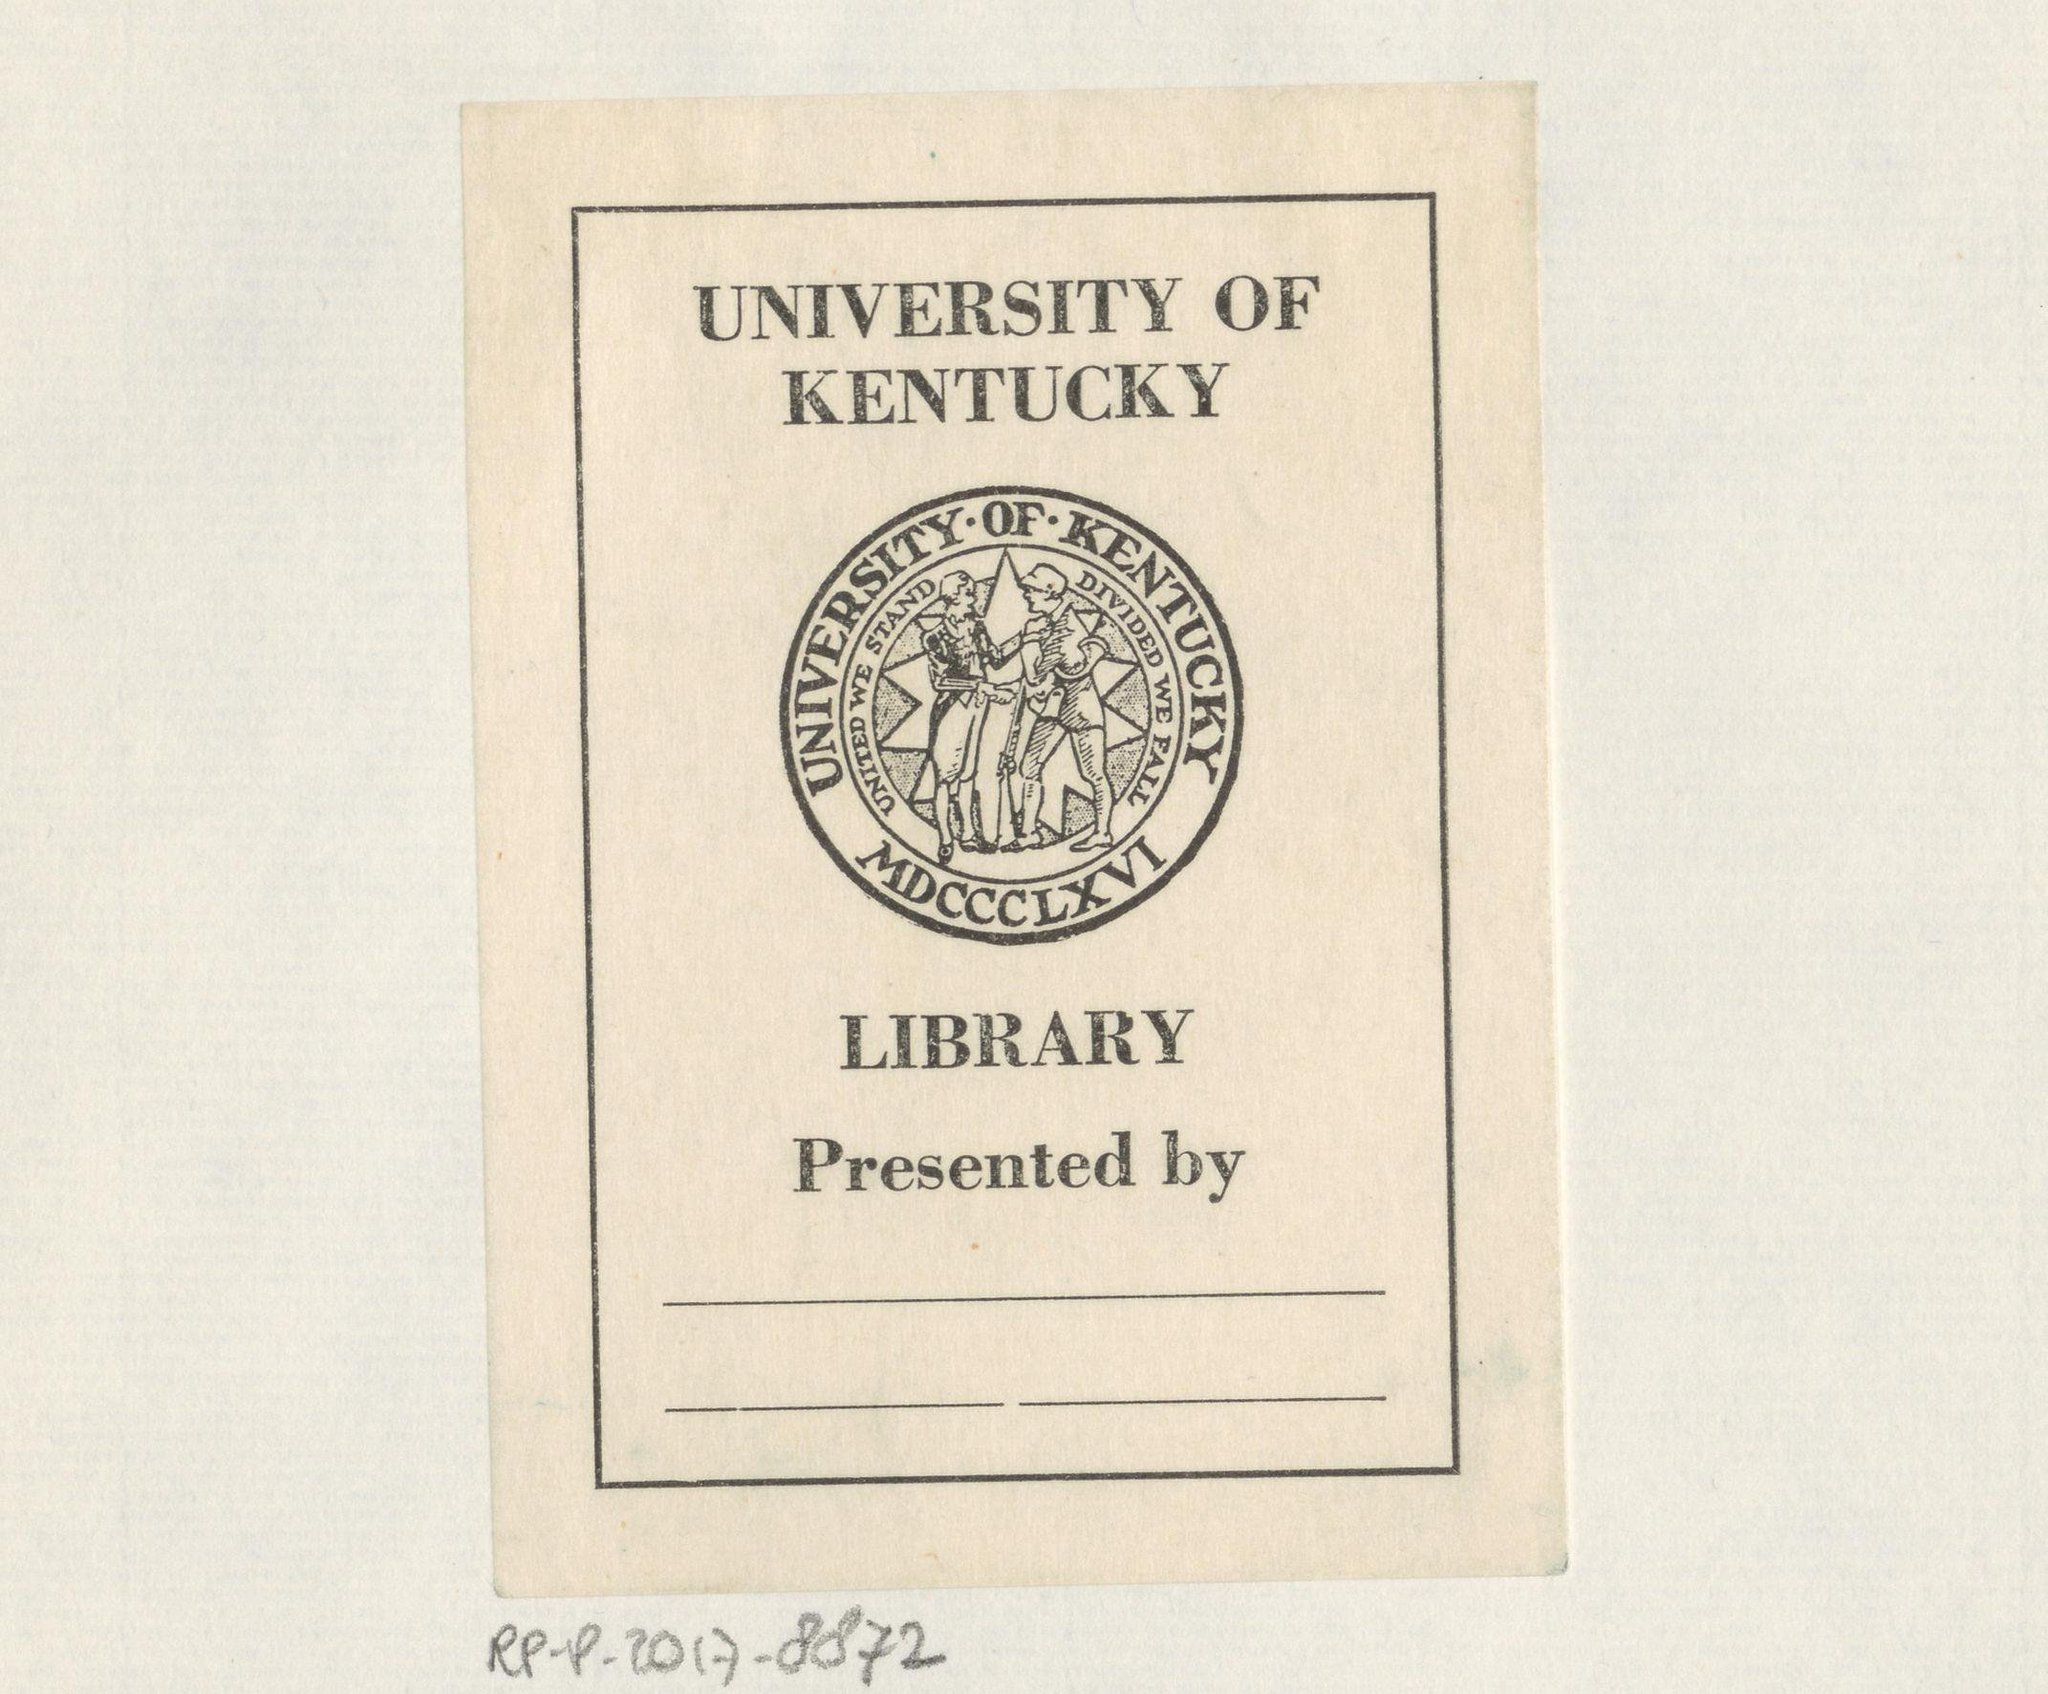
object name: bookplate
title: Ex libris van de University of Kentucky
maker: Anonymous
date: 1866-1999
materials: paper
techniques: printing block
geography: north and central america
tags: university of kentucky, kentucky, amerikaanse burgeroorlog